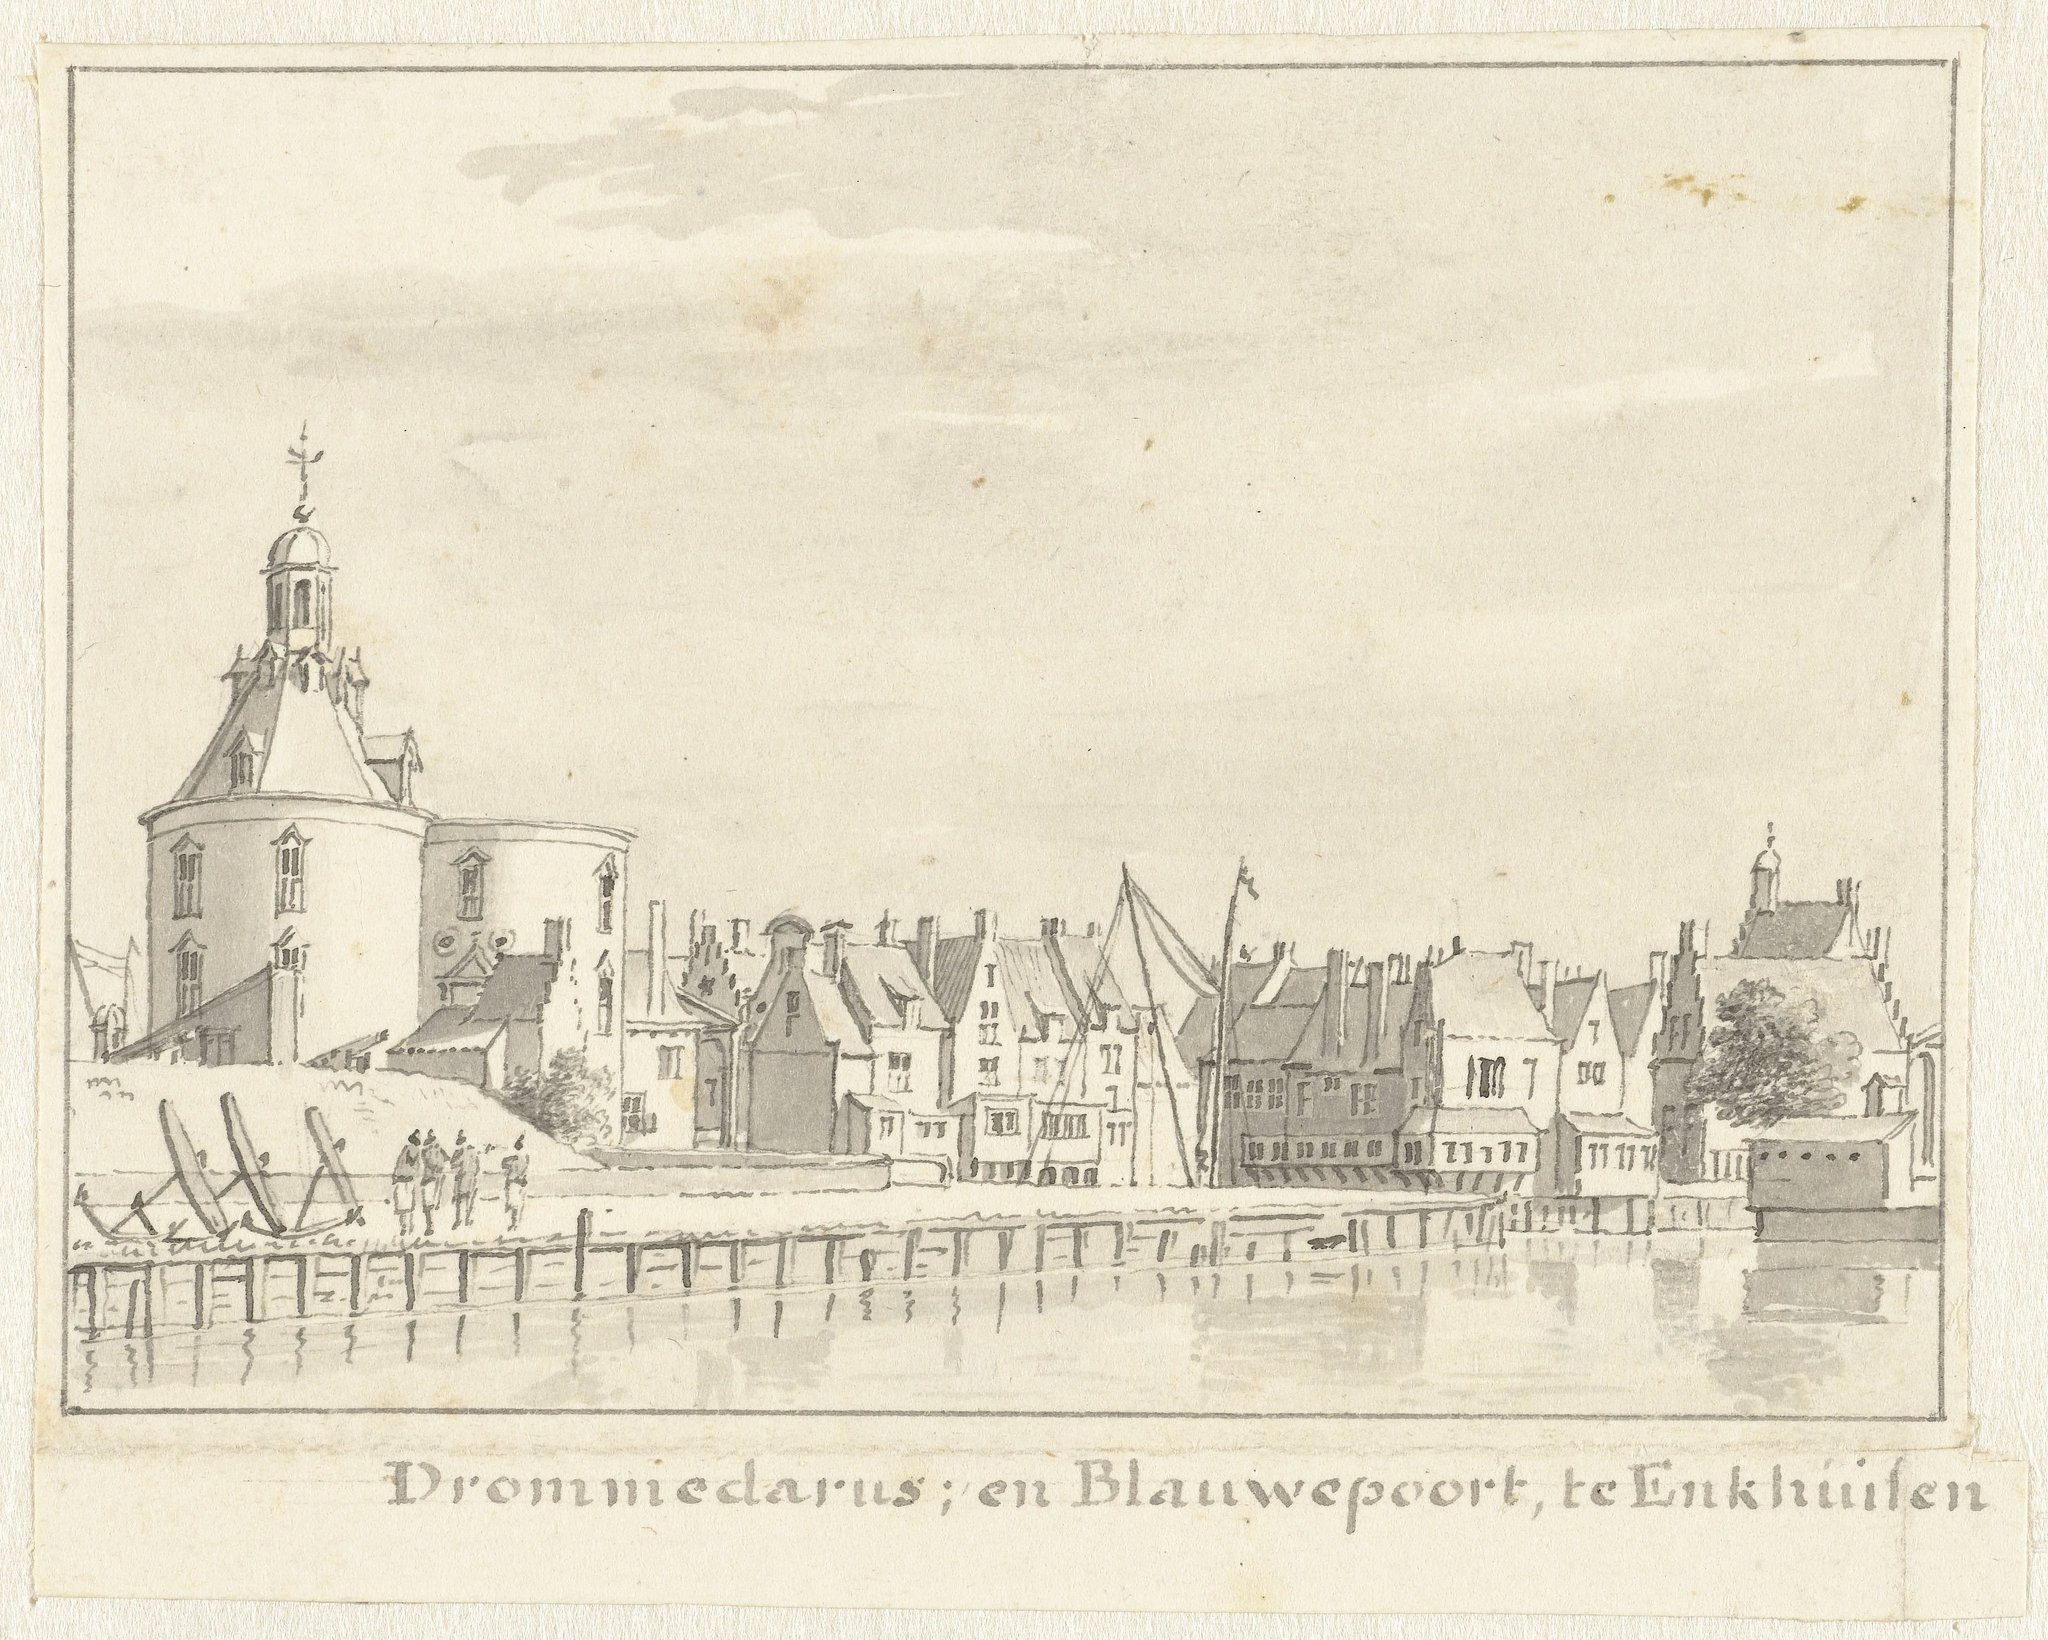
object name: design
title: De Drommedaris en Blauwepoort te Enkhuizen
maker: cornelis pronk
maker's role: draughtsman, painter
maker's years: 1691-1759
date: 1701-1759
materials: ink, paper, pencil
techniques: brush, pen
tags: city-gate